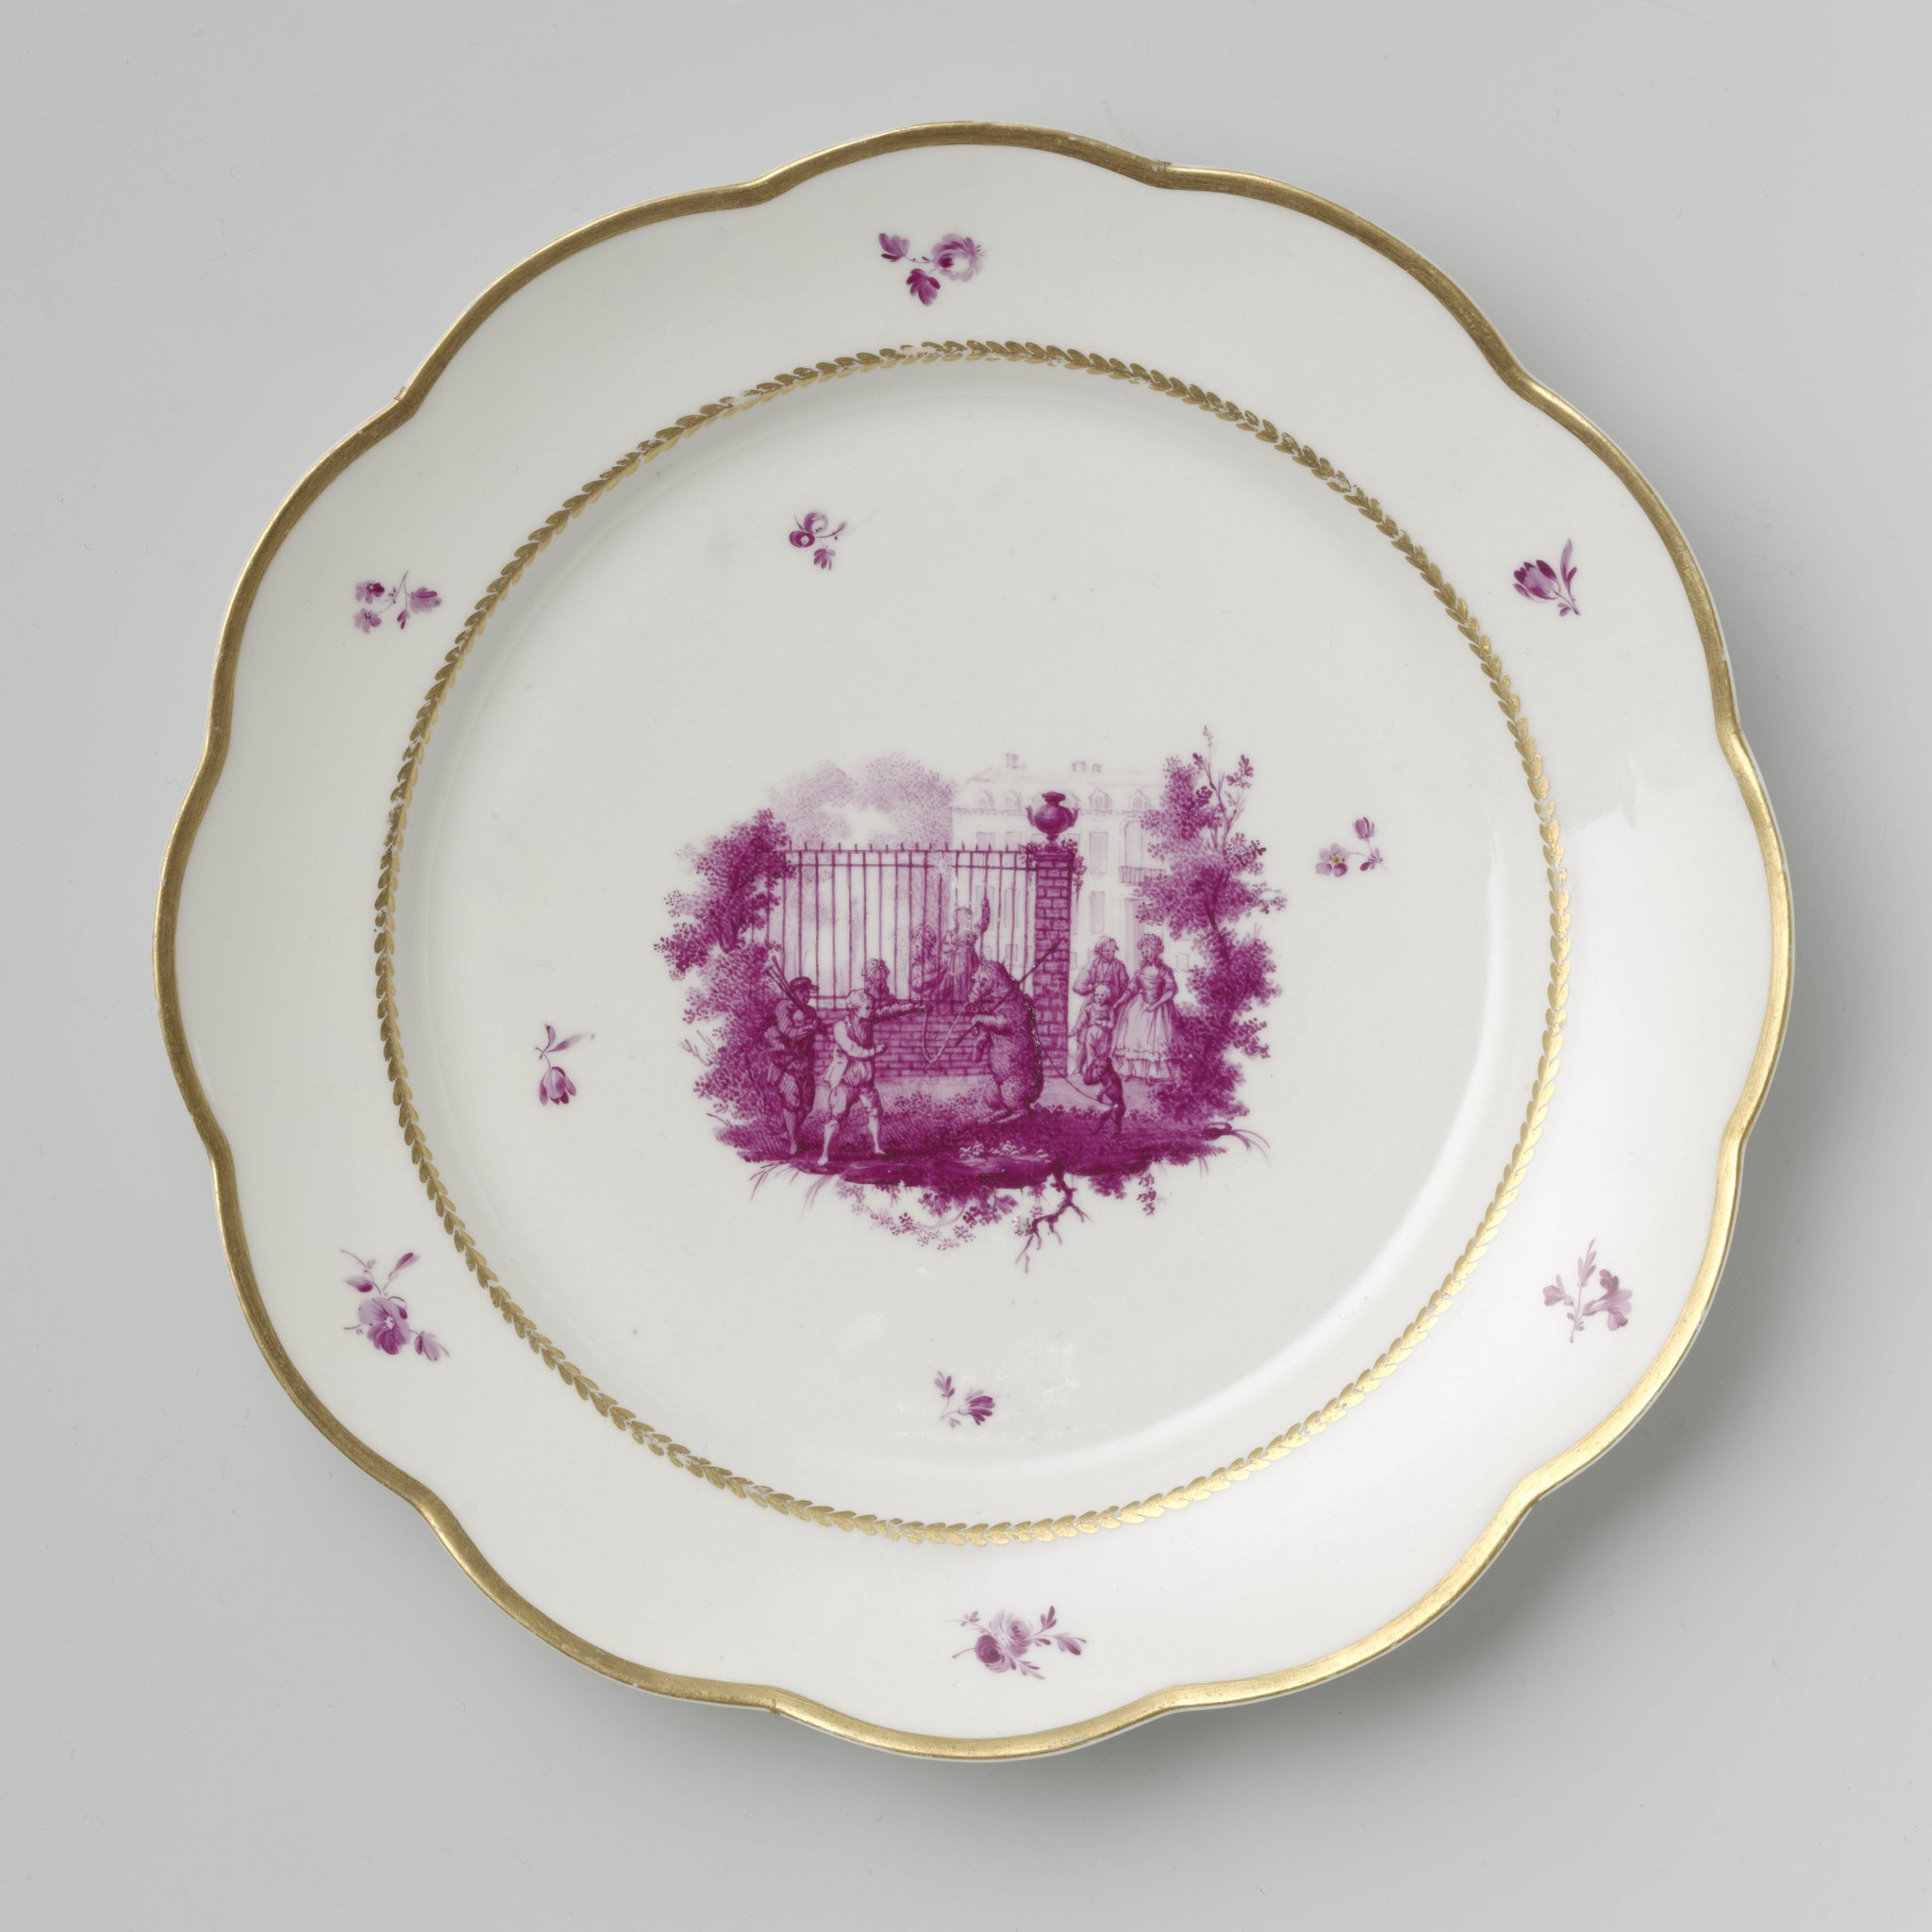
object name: plate dish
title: Schotel of bord met dansende beer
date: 1774-1784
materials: porcelain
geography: loosdrecht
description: Two plates. Porcelain. Loosdrecht, c. 1778 - 1782. Factory of Joannes de Mol.